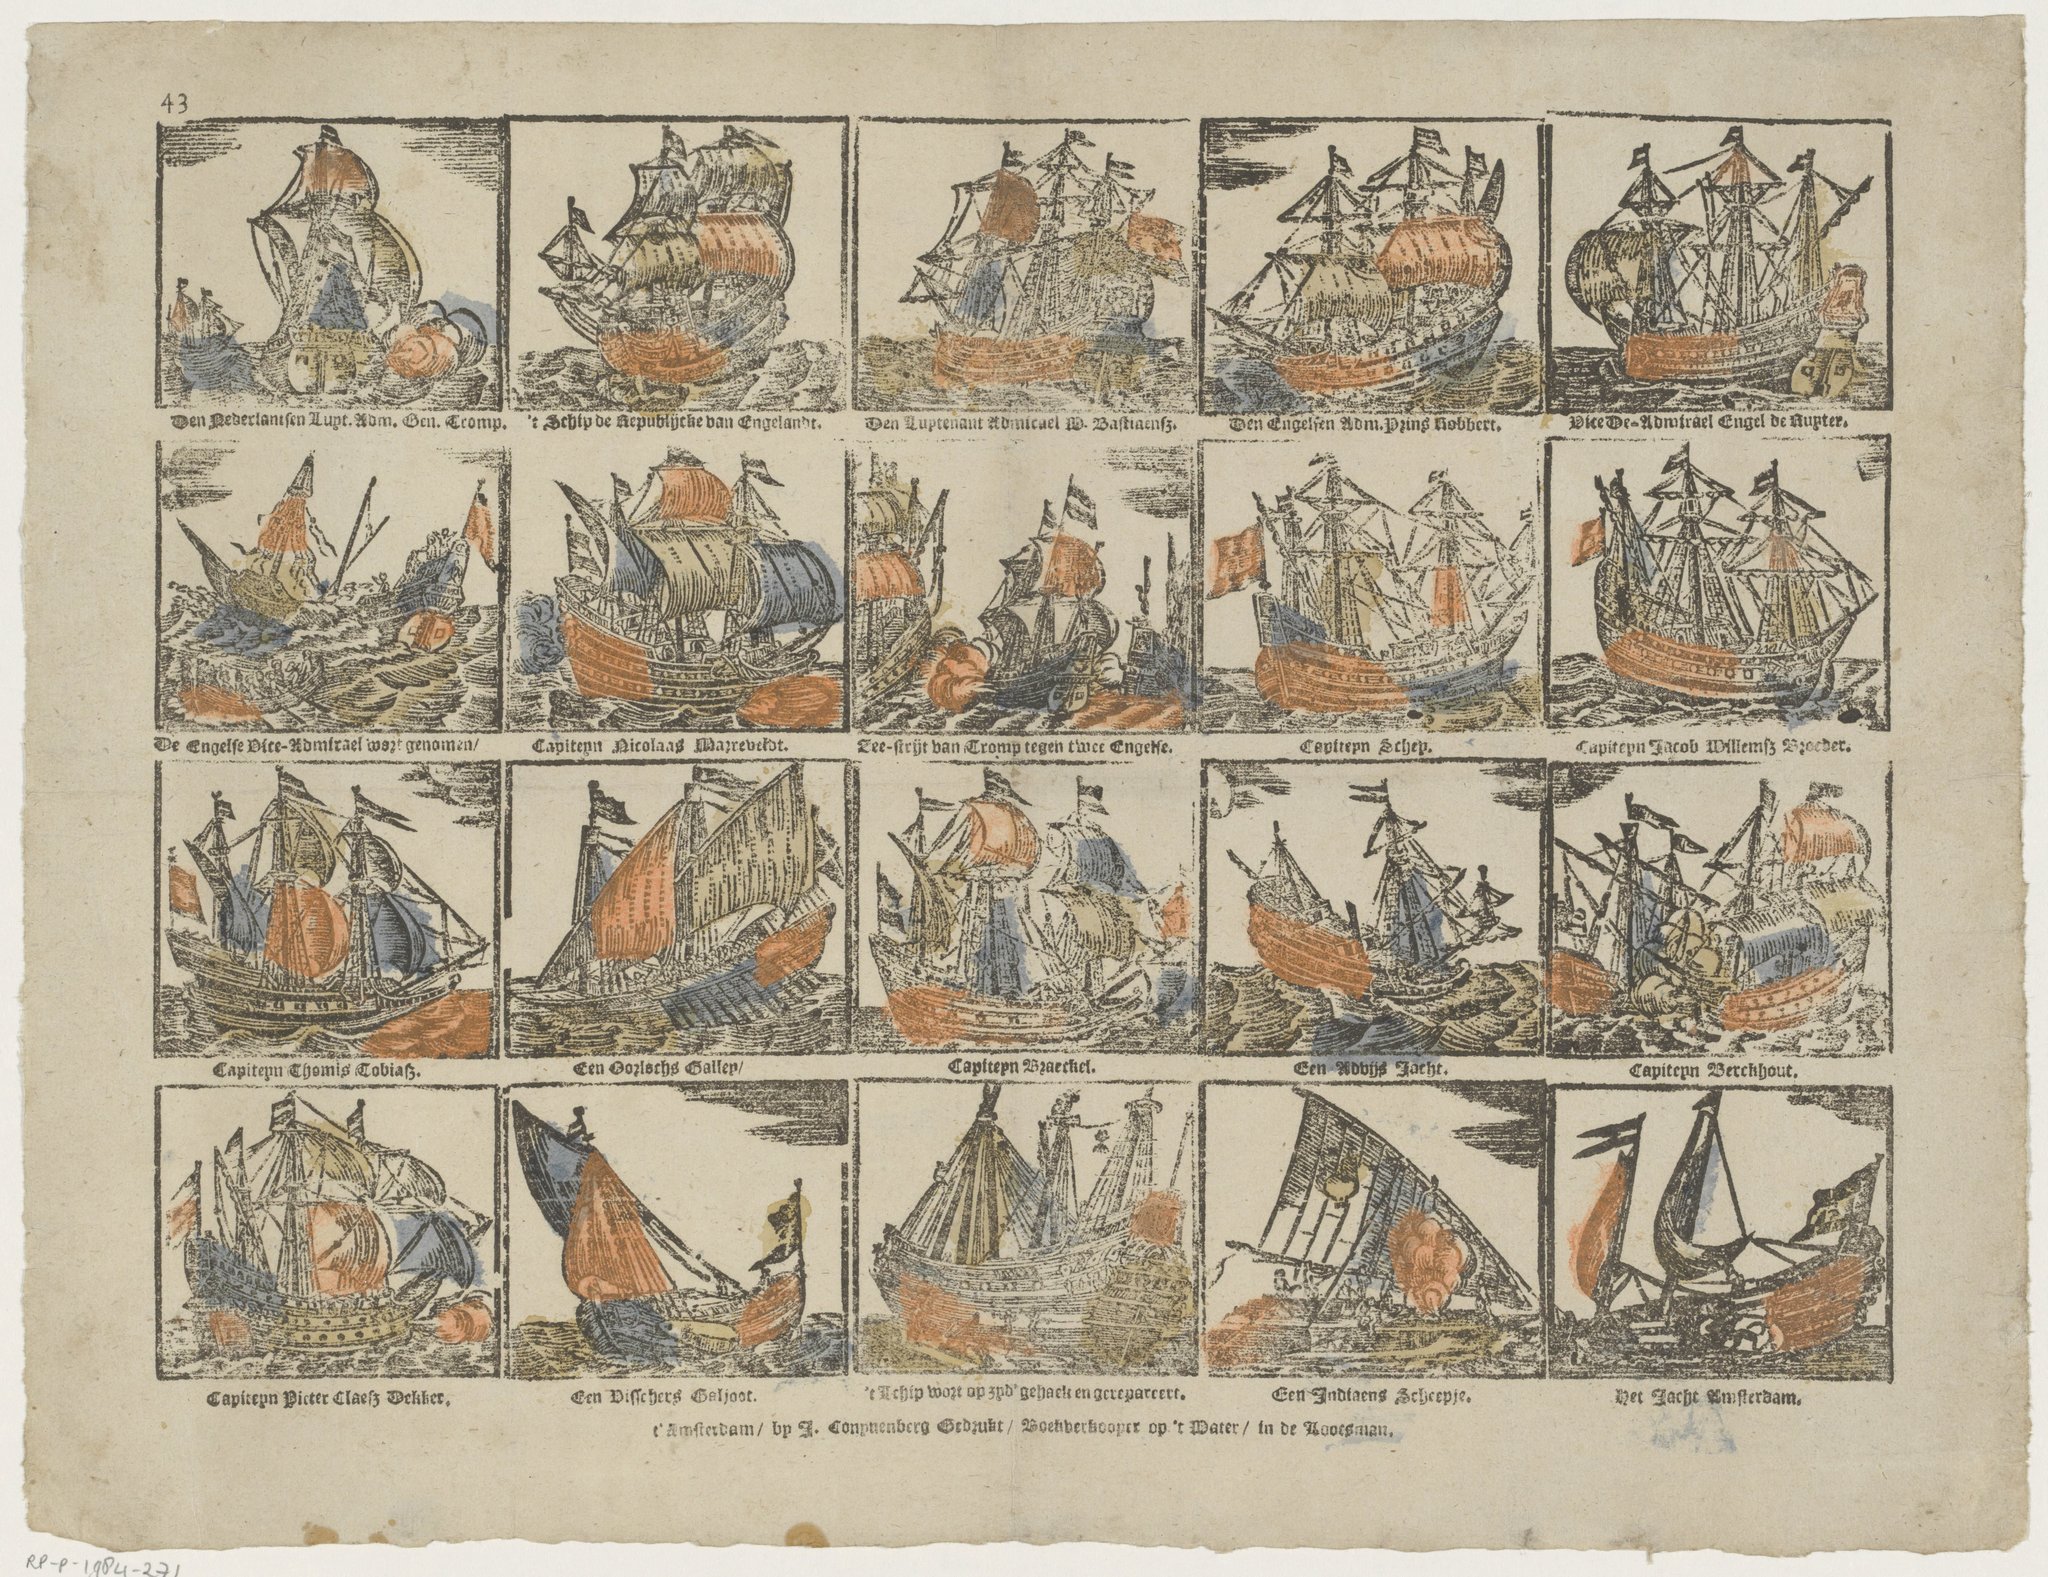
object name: popular print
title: Oorlogsschepen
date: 1711-1723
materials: paper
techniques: colour, letterpress printing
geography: netherlands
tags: military vehicles (+ sailing-ships), ships (in general)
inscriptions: collector's mark: Lugt 2228, collector's mark: Lugt 2760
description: Blad met 20 voorstellingen van verschillende oorlogsschepen op zee. Onder elke afbeelding een onderschrift. Genummerd linksboven: 43.